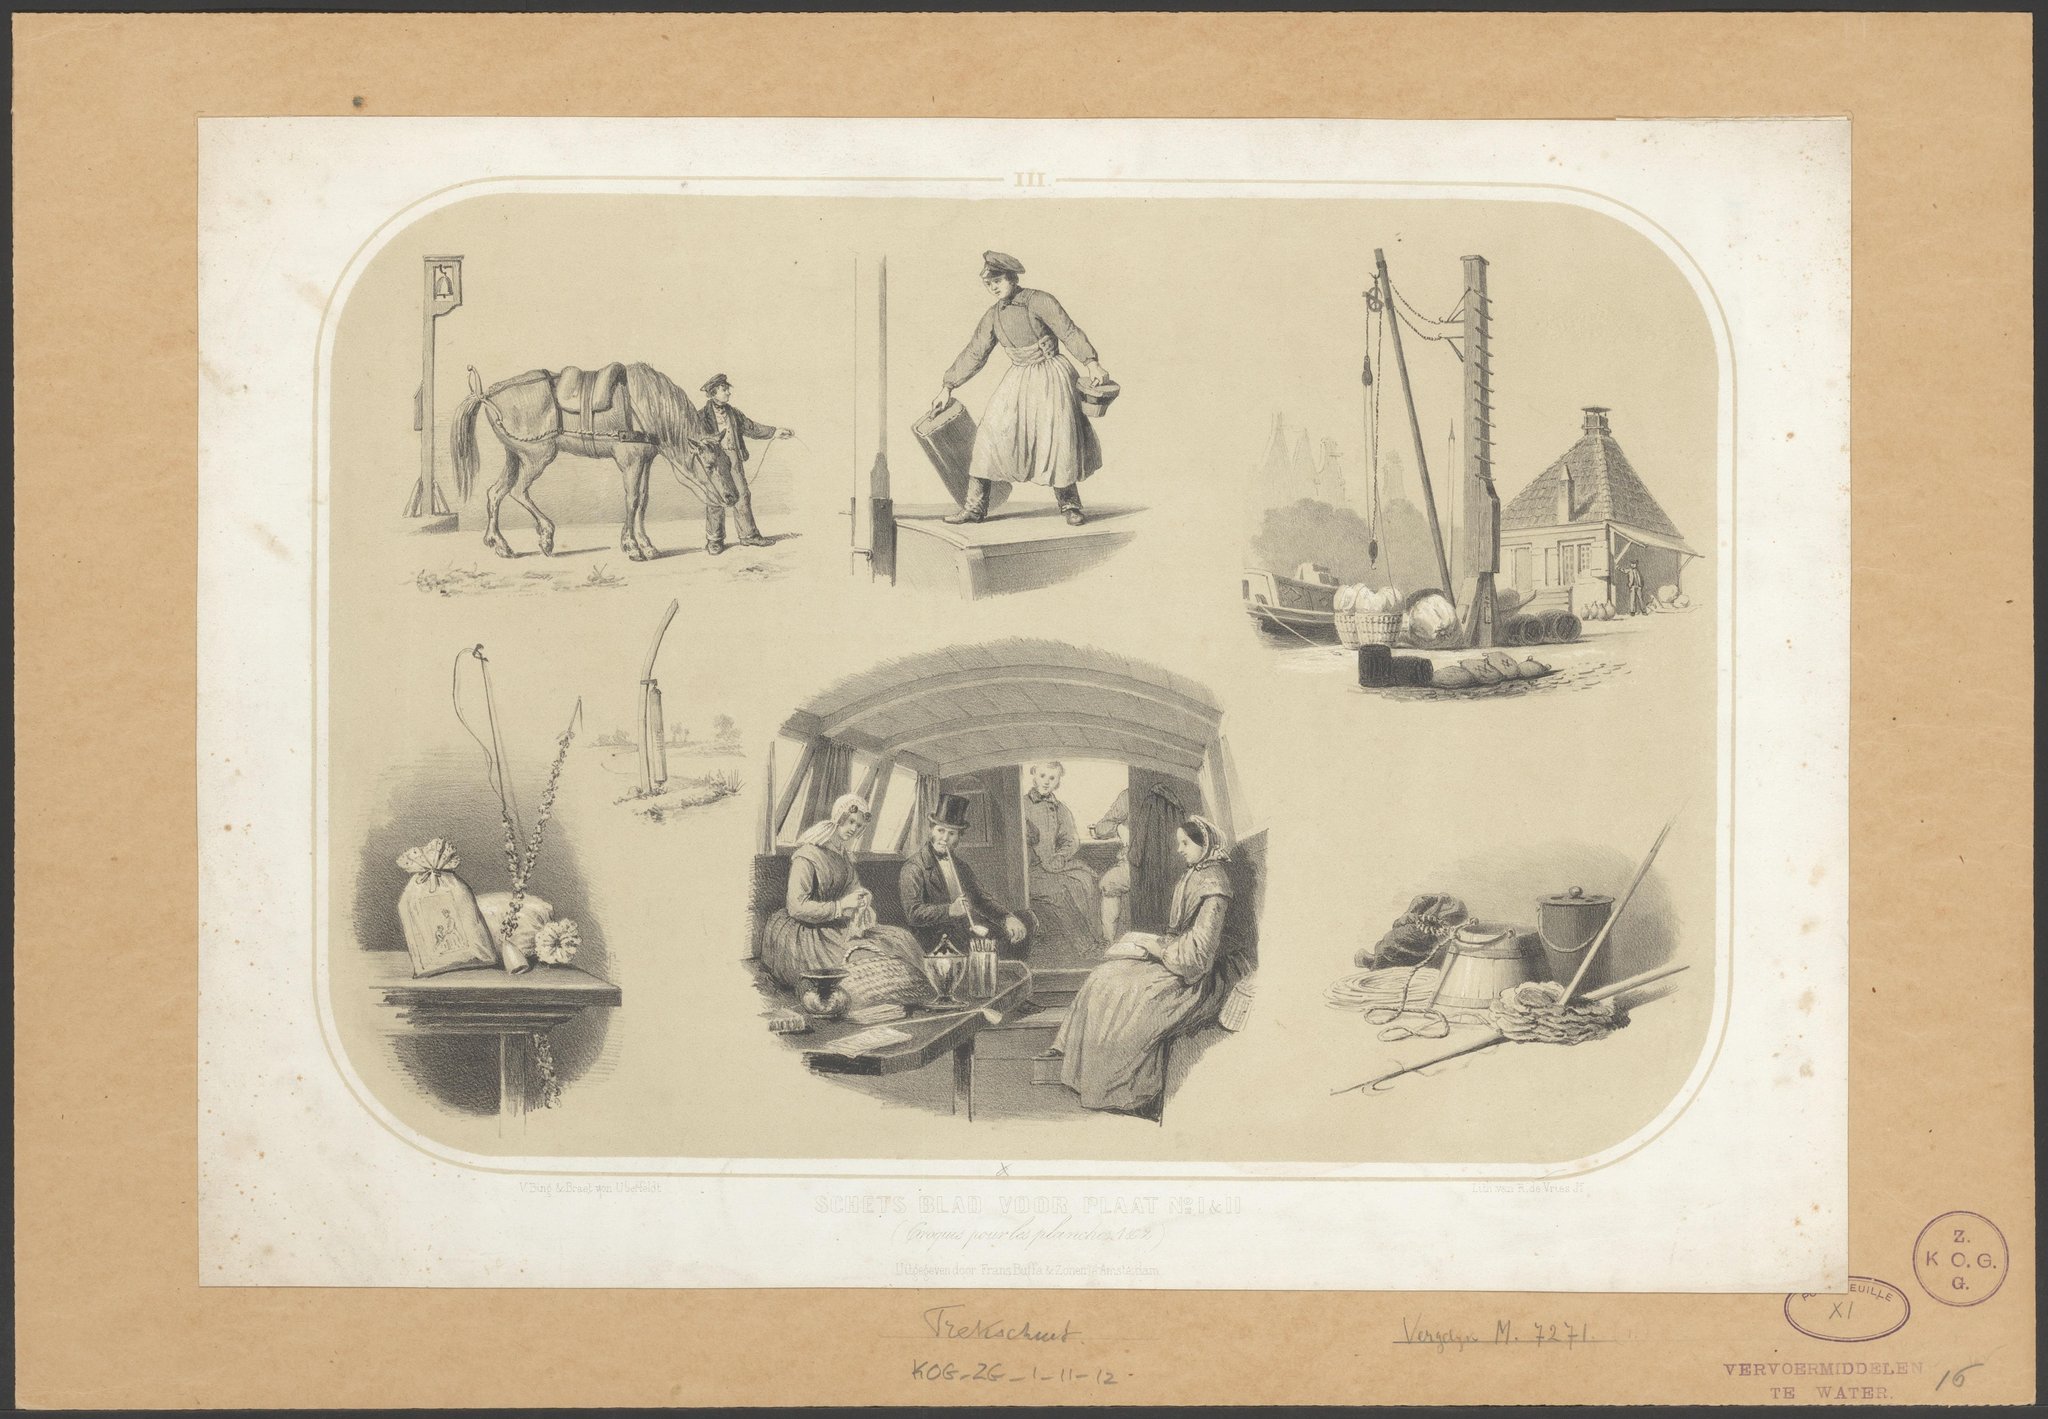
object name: print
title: Schetsen van het dagelijks leven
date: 1840-1860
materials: paper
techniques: tone lithography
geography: amsterdam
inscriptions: stamp, stamp, collector's mark: Lugt 1641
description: Zes voorstellingen met betrekking tot de trekschuit. Bovenaan het trekpaard, de steiger en het veerhuis. Onderaan het interieur van de trekschuit en diverse voorwerpen aan boord. Bovenaan genummerd: III. Onderwerpsrubrieken binnen de Atlas Zeden en Gewoonten: Handel, nijverheid en verkeer, Vervoermiddelen te land en te water, Vervoermiddelen te water.